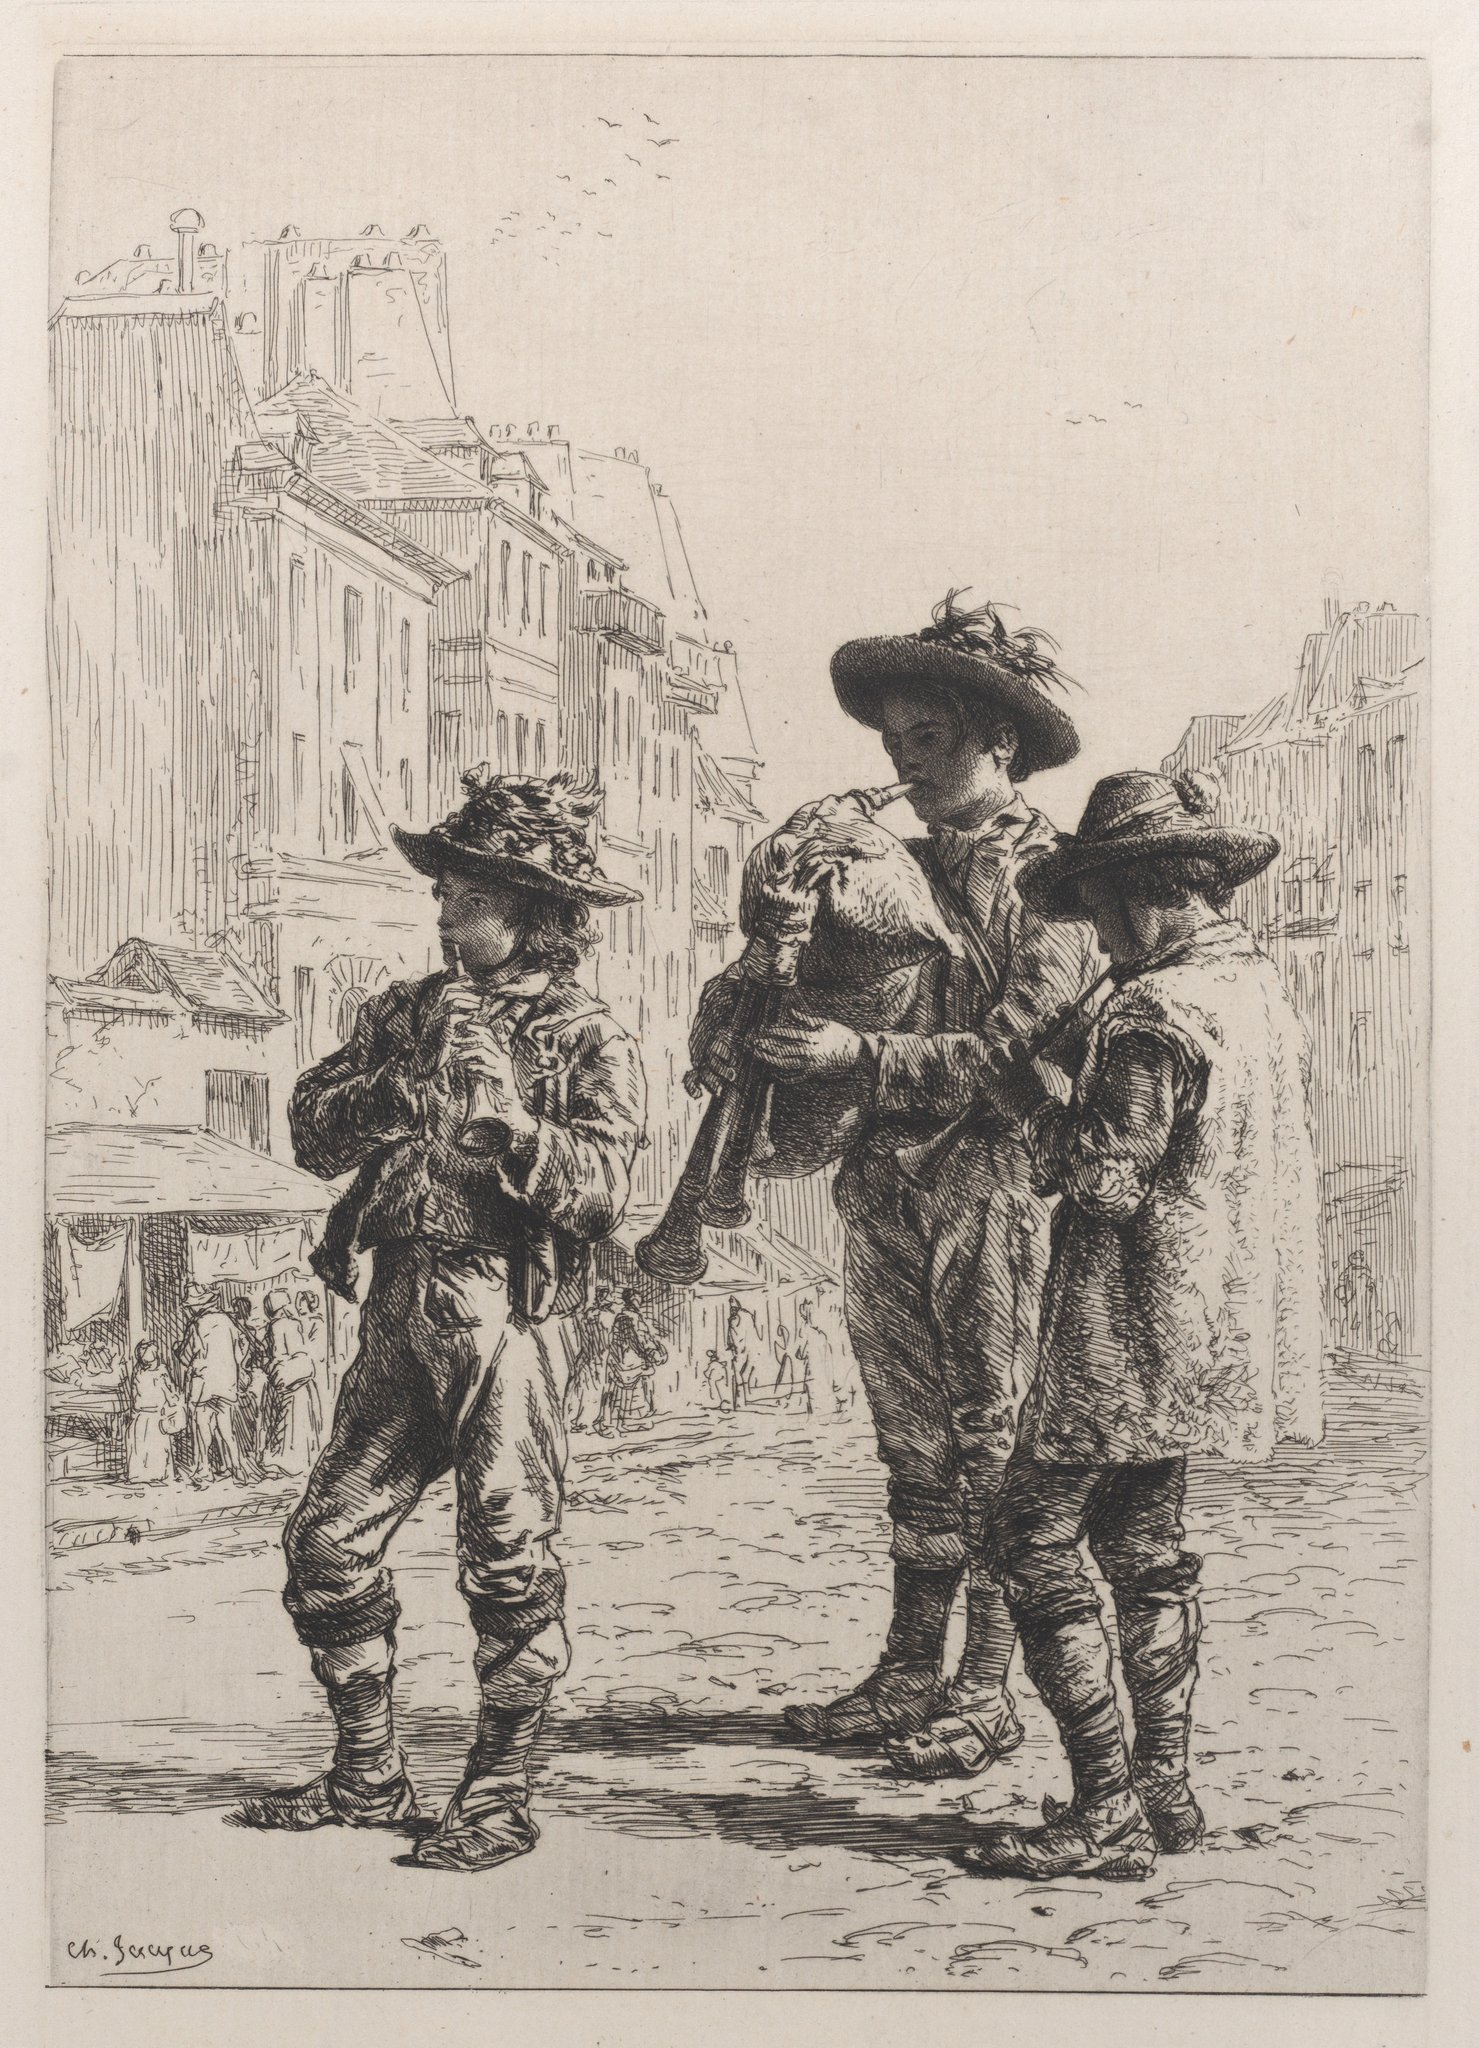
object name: print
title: Pifferaris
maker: charles émile jacque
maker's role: artist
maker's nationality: french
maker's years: 1813-1894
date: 1864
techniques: etching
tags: musical instruments,boys,bagpipes